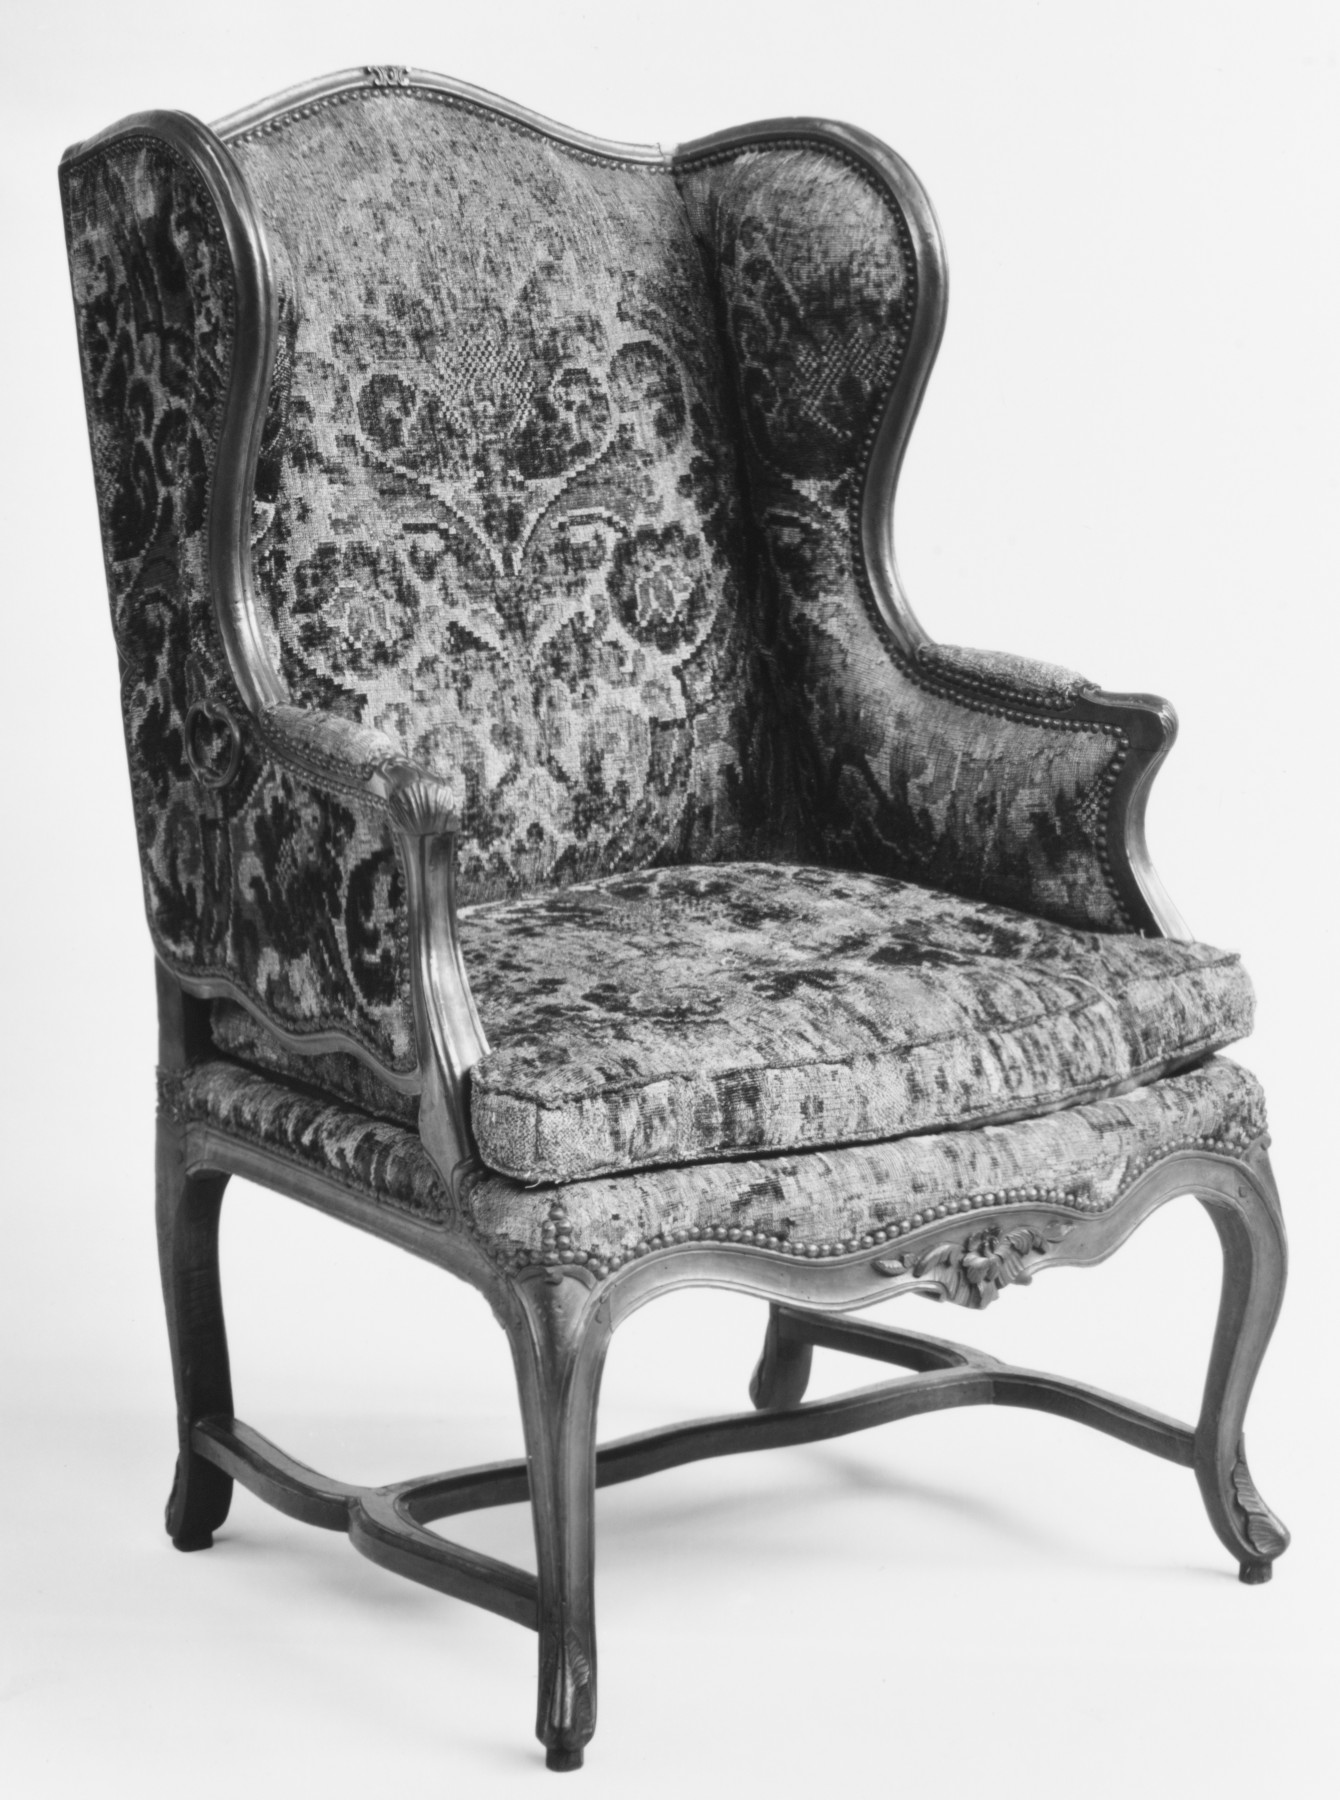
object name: armchair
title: Armchair (bergère)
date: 1726-1750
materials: wood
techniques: carving